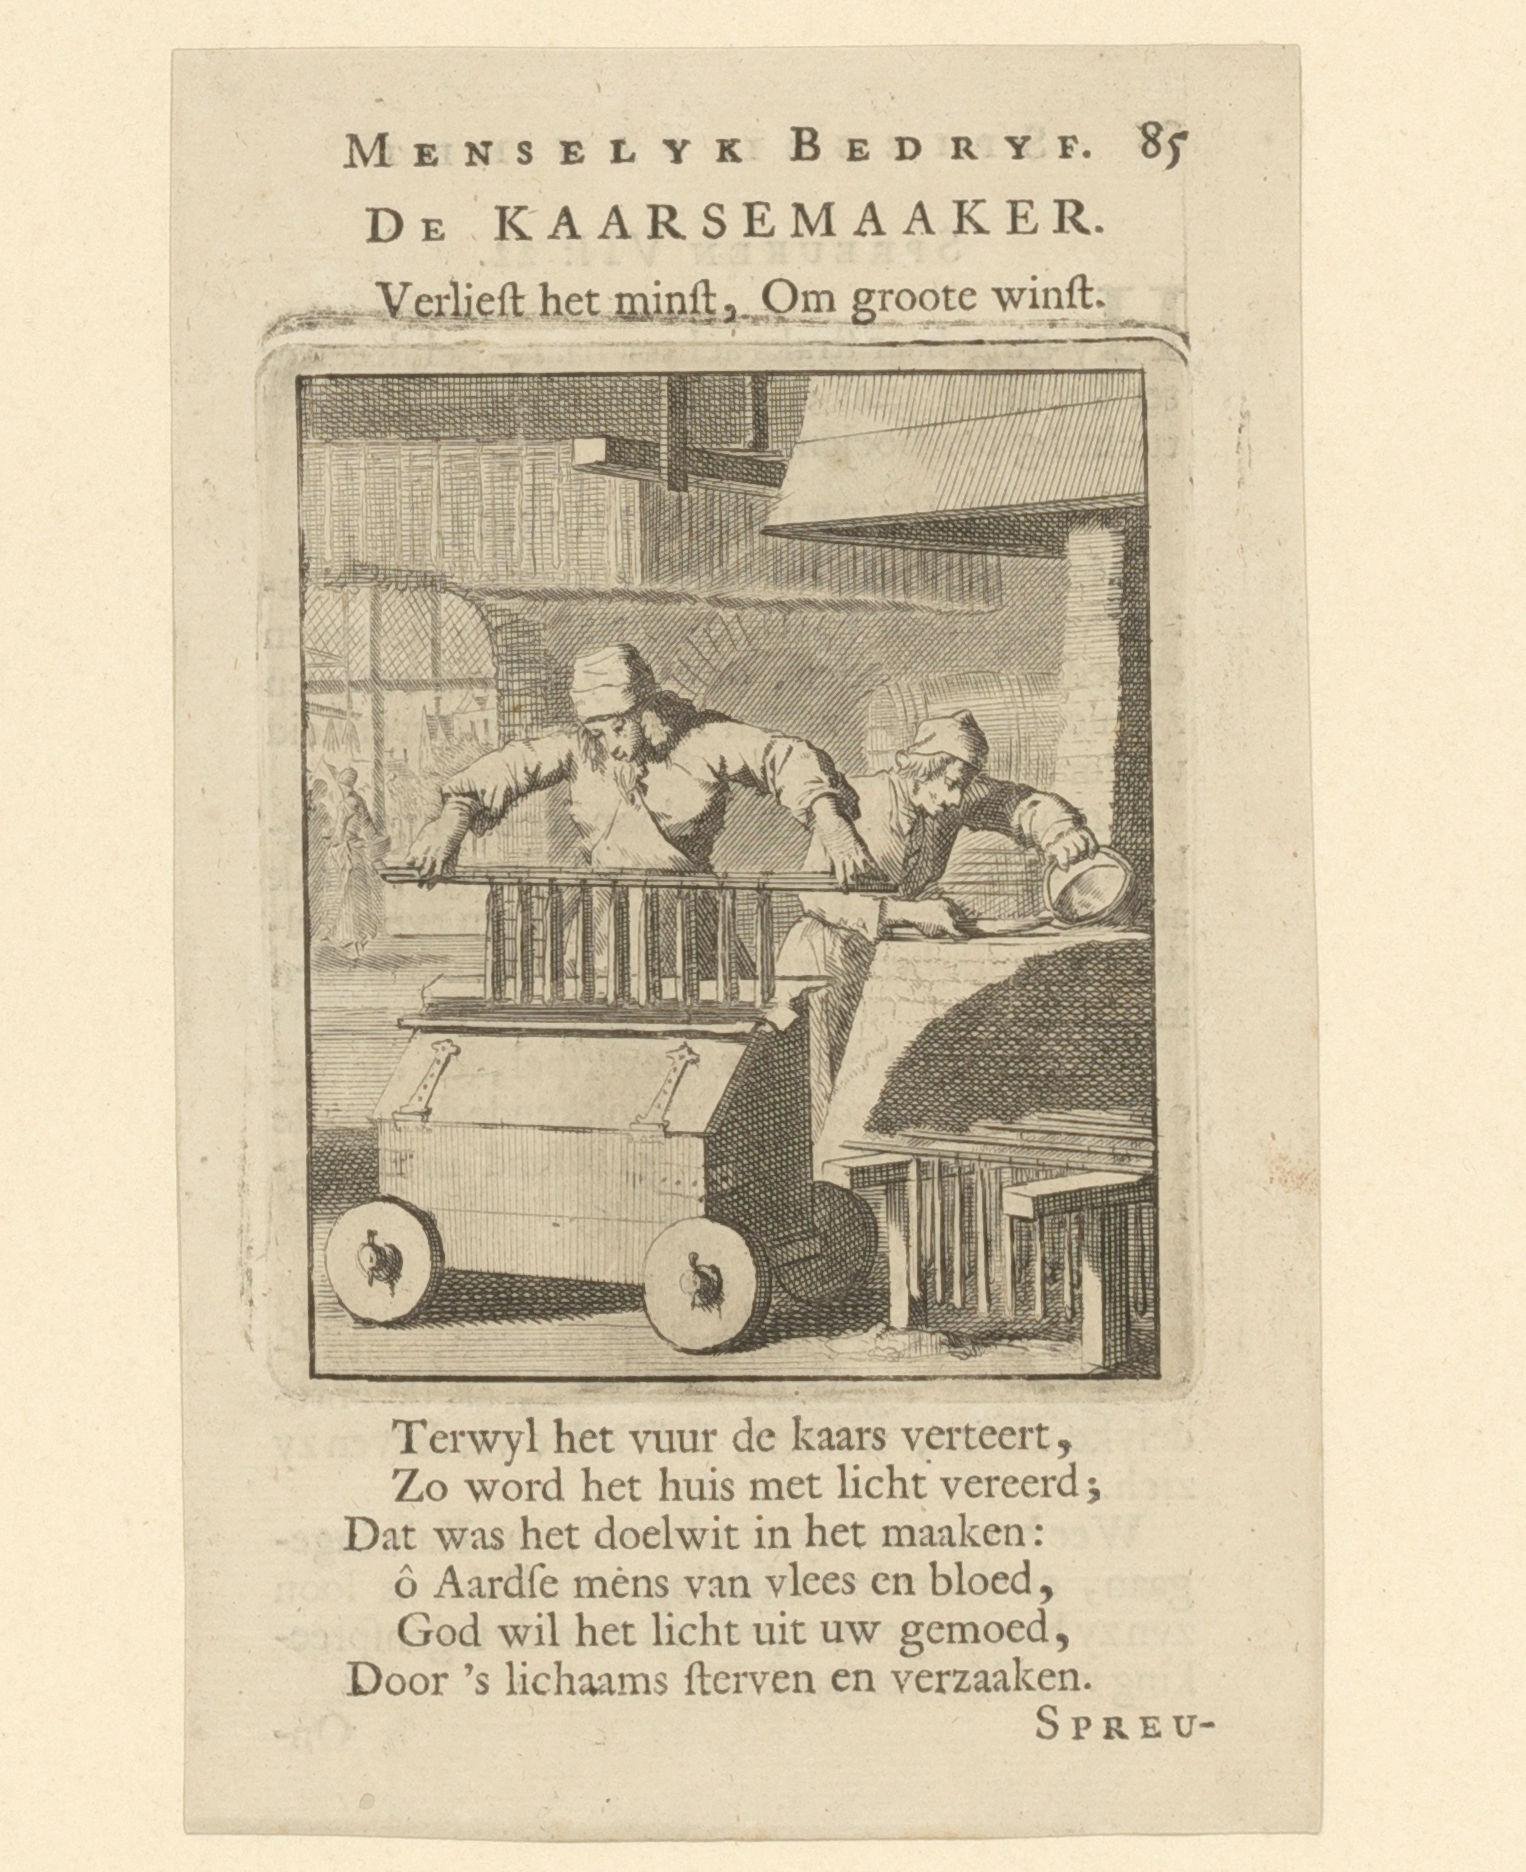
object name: print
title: De Kaarsemaaker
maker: jan luyken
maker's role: draughtsman, print maker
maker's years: 1649-1712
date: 1694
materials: paper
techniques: engraving, etching, letterpress printing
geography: netherlands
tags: handicrafts, craftsman at work, candle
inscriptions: collector's mark, collector's mark: Lugt 1641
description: Een kaarsenmaker aan het werk in de werkplaats. Onderaan een zesregelig vers. Bedrukt met tekst op verso. Onderwerpsrubrieken binnen de Atlas Zeden en Gewoonten: Mannelijk beroep en bedrijf: Lantaarnmaker, olieslager, kaarsenmaker.